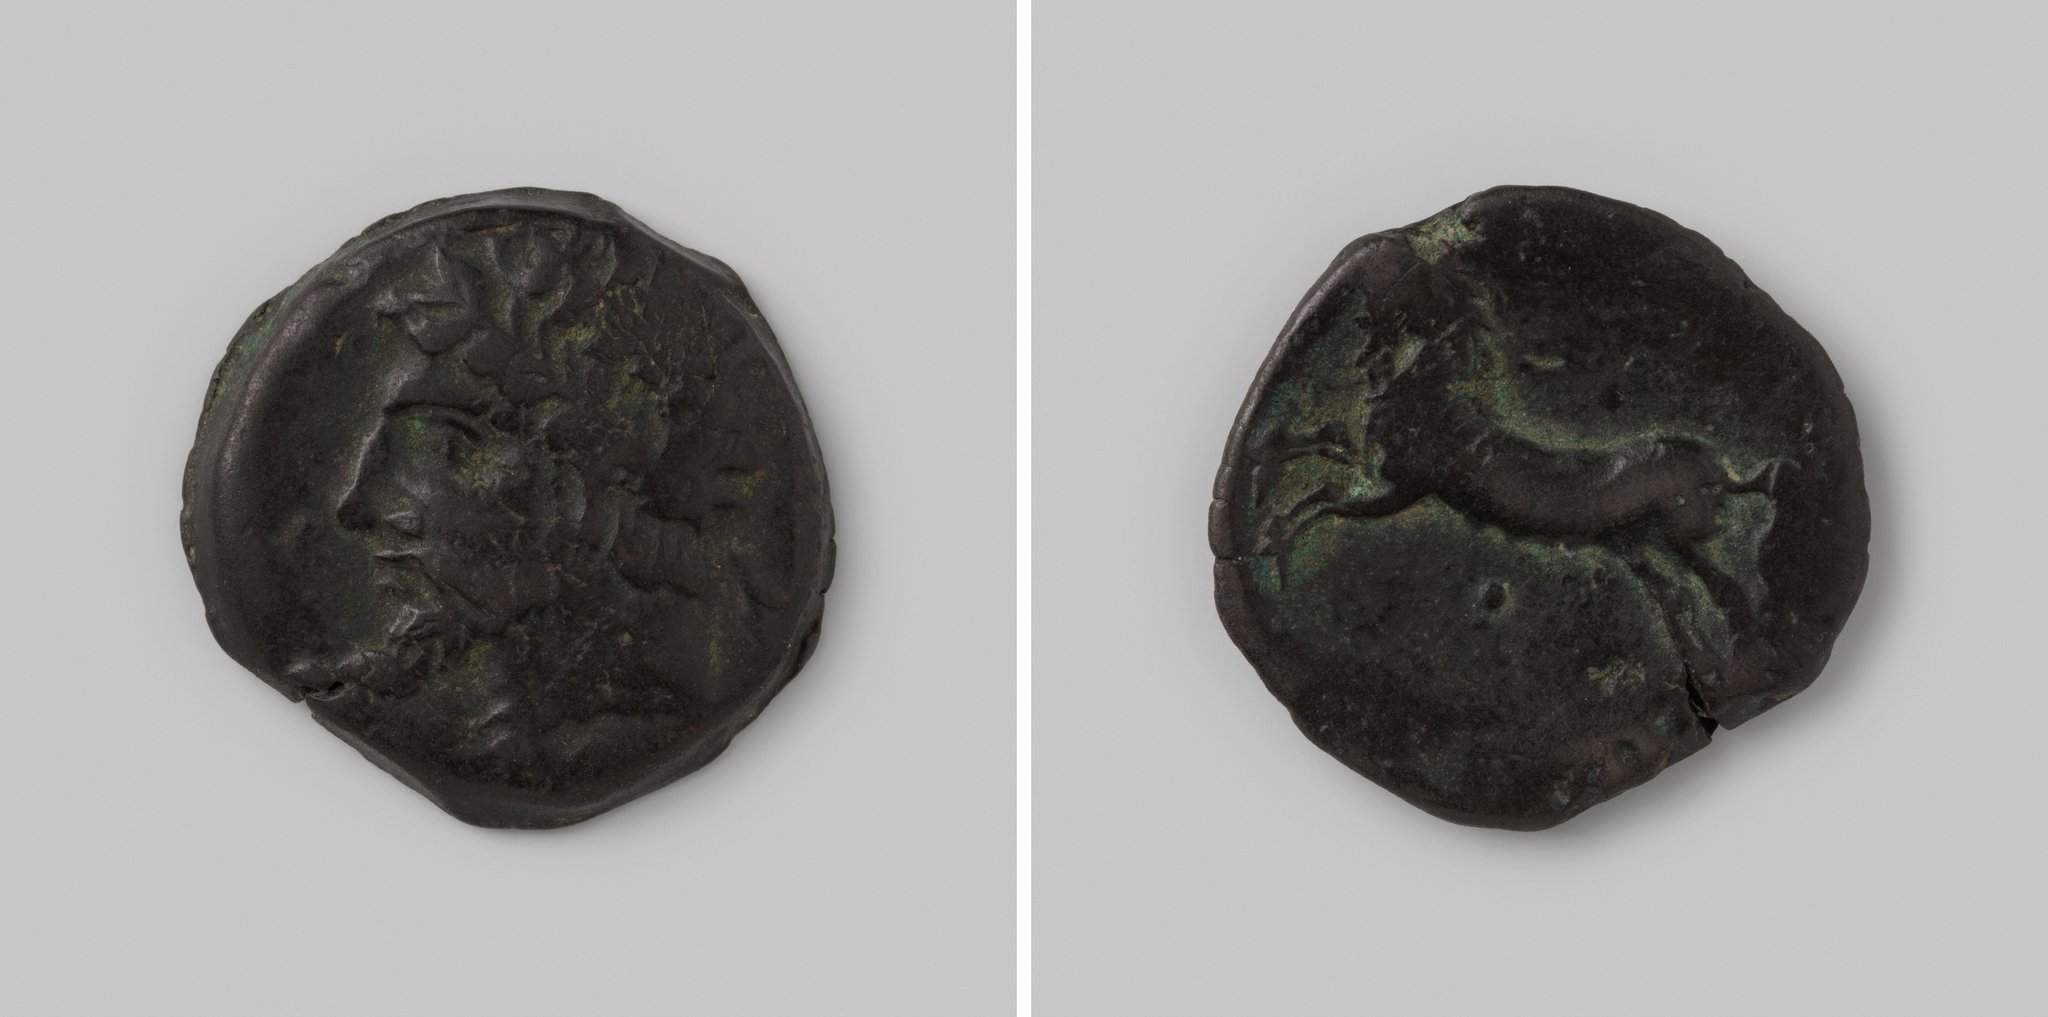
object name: coin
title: Munt uit Mauretanië van koning Masinisia, -202 - -148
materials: bronze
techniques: striking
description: Bronzen munt. Voorzijde: gelauwerd hoofd naar links. Keerzijde: paard in galop naar links, waaronder stip.